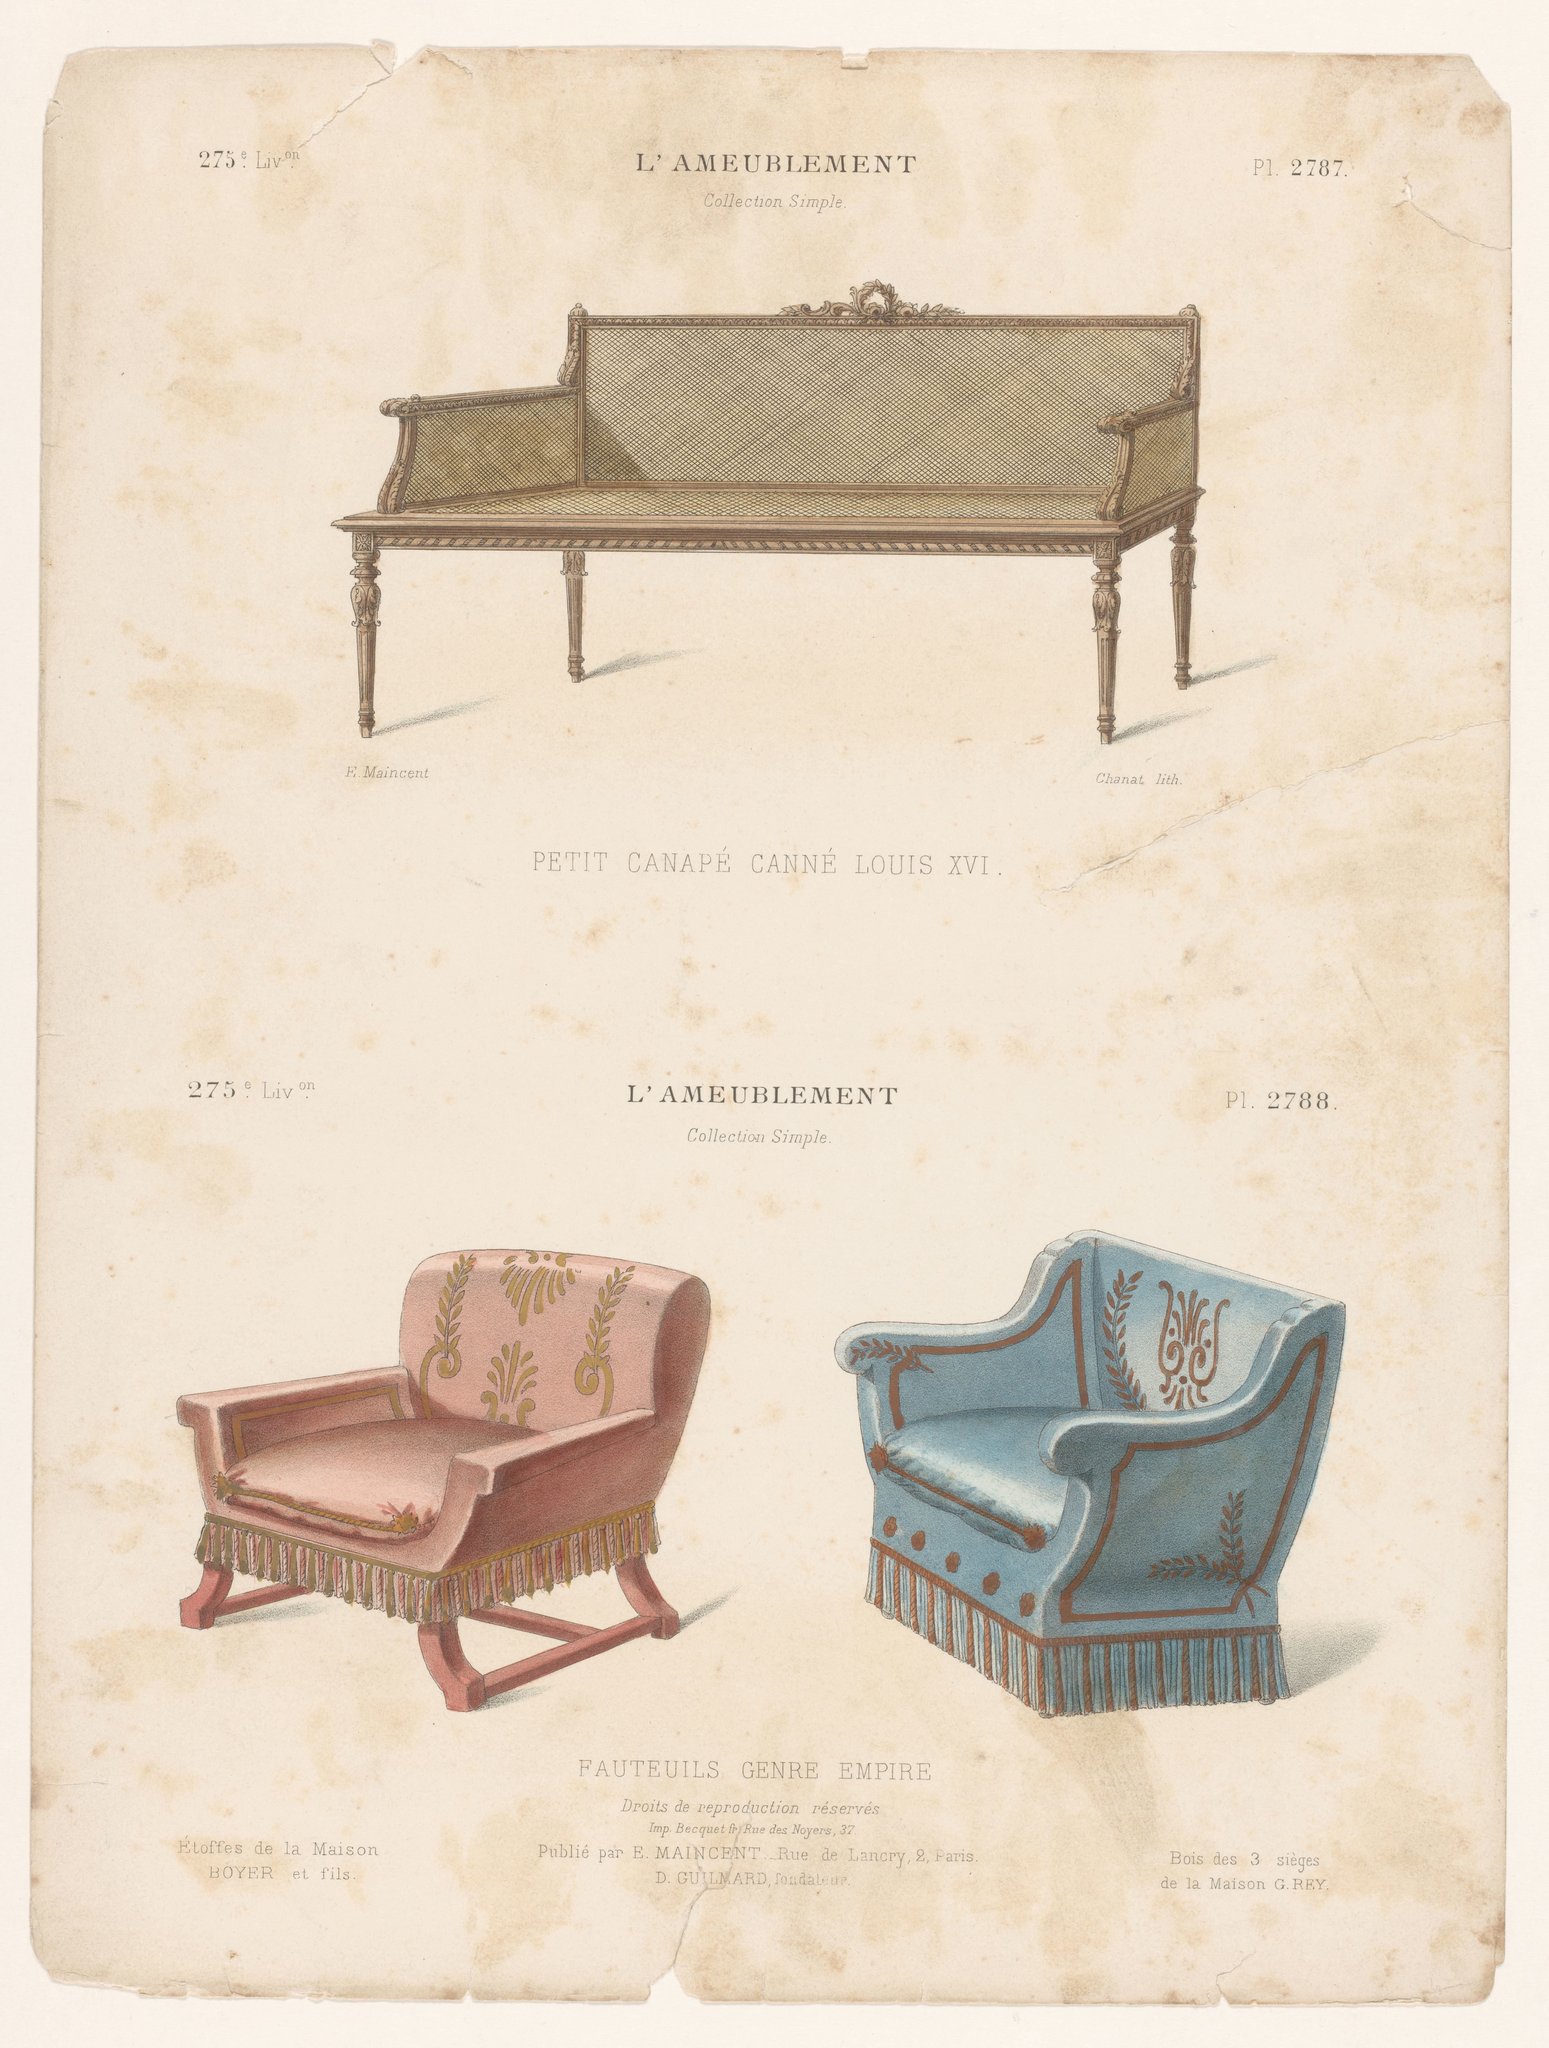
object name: print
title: Canapé en twee fauteuils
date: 1885-1895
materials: paper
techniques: hand coloring, lithograph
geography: paris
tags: shelves, rack, sideboard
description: Een canapé in de Lodewijk XVI-stijl en twee empire fauteuils. Prent uit 275e Livraison.